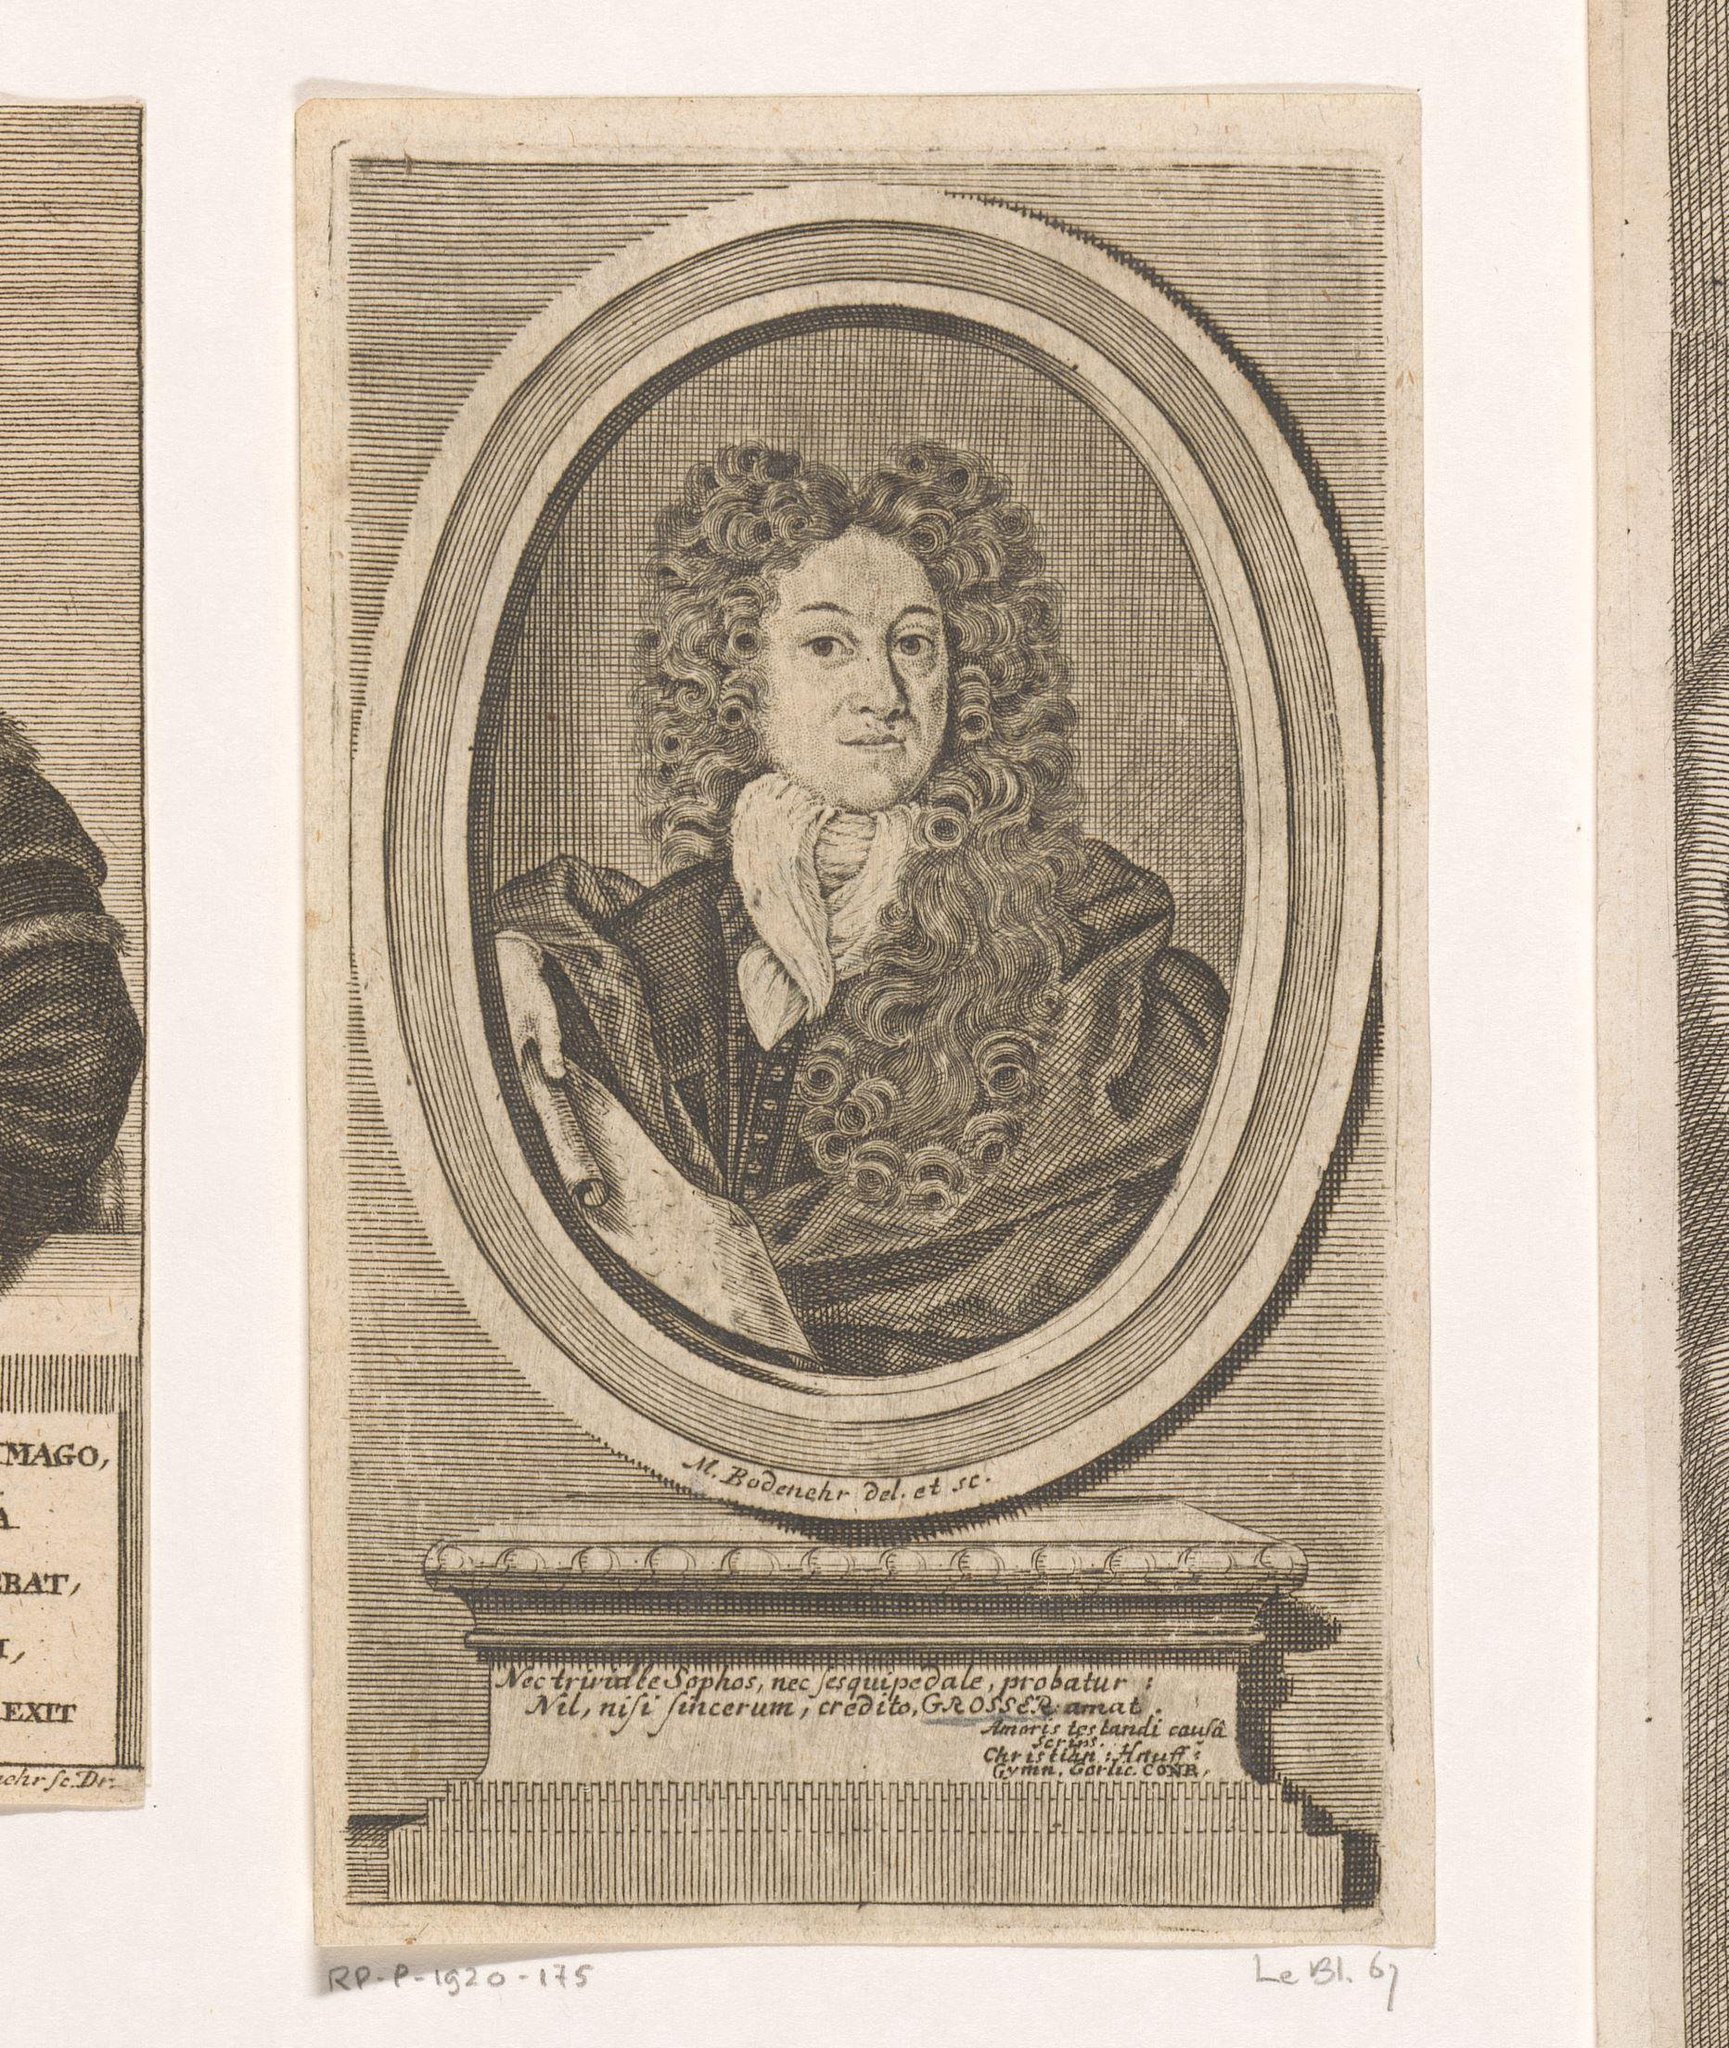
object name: print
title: Portret van Samuel Grosser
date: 1675-1748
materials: paper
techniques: engraving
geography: dresden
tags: historical persons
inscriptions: collector's mark: Lugt 2228